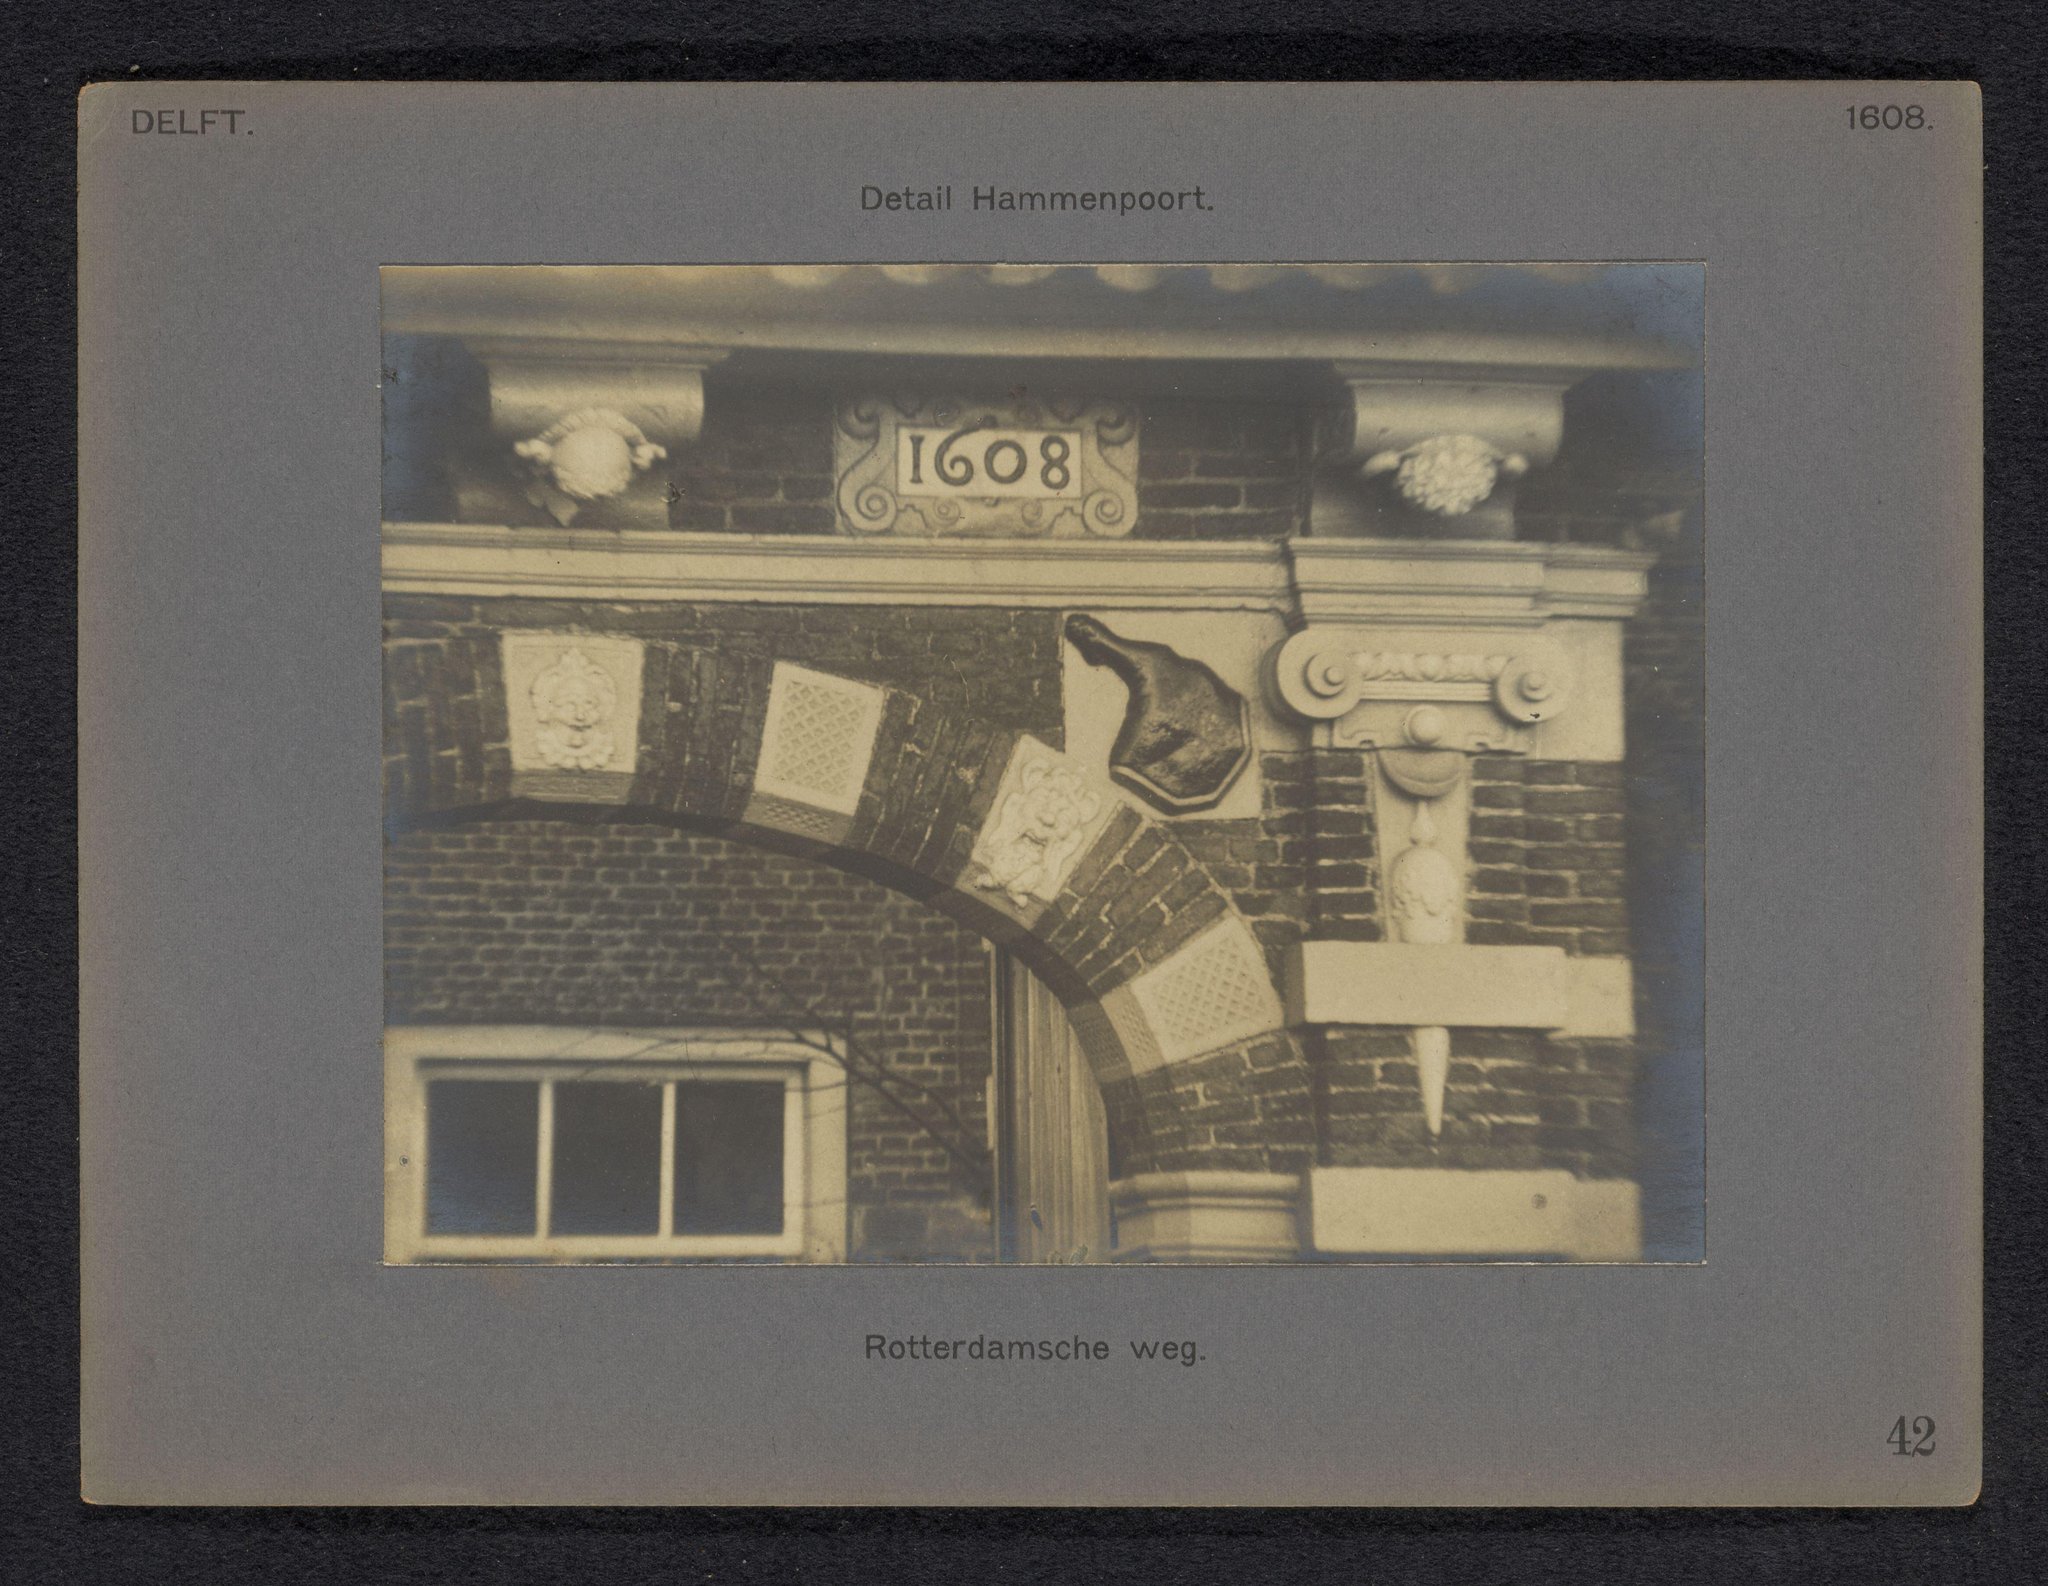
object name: photograph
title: Rotterdamsche weg. Detail Hammenpoort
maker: Anonymous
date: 1900-1904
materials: cardboard, photographic support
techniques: gelatin silver print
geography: delft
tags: gate, entrance, ham, delft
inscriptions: inscription: ‘Delft. 1608’, number: ‘42’, inscription: ‘Het recht van reproductie dezer photo's wordt door den Uitgever voorbehouden.’